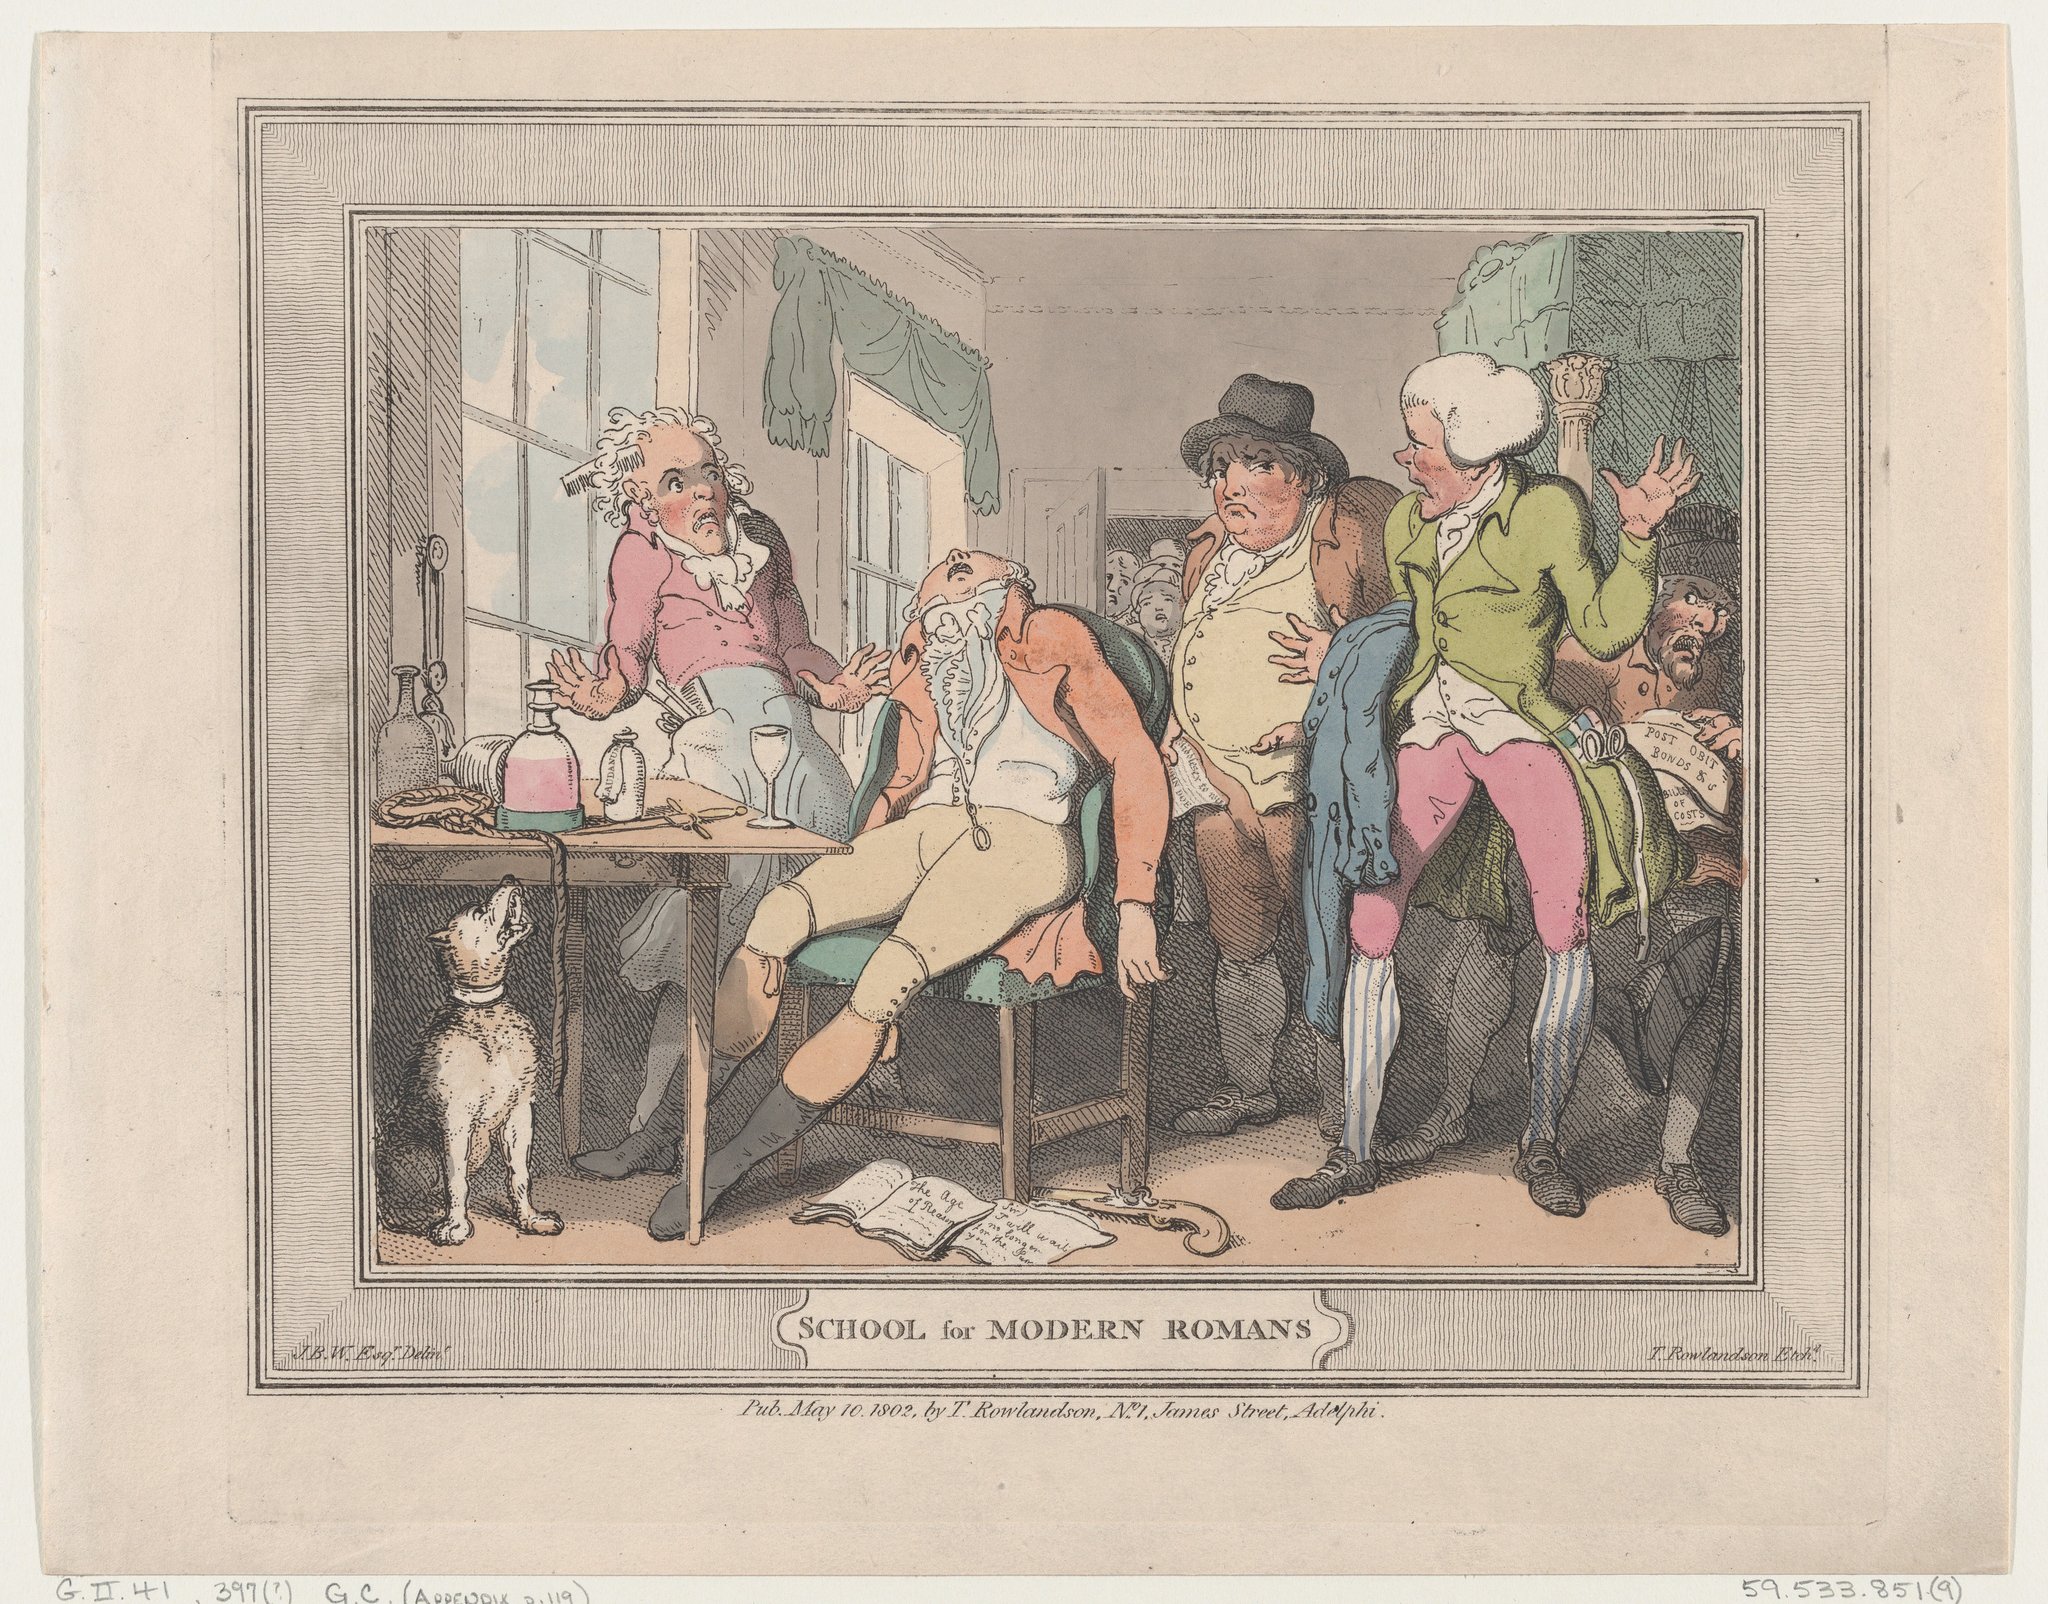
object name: print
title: School for Modern Romans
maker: thomas rowlandson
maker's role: artist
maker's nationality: british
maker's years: 1757-1827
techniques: etching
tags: satire,men,women,dogs